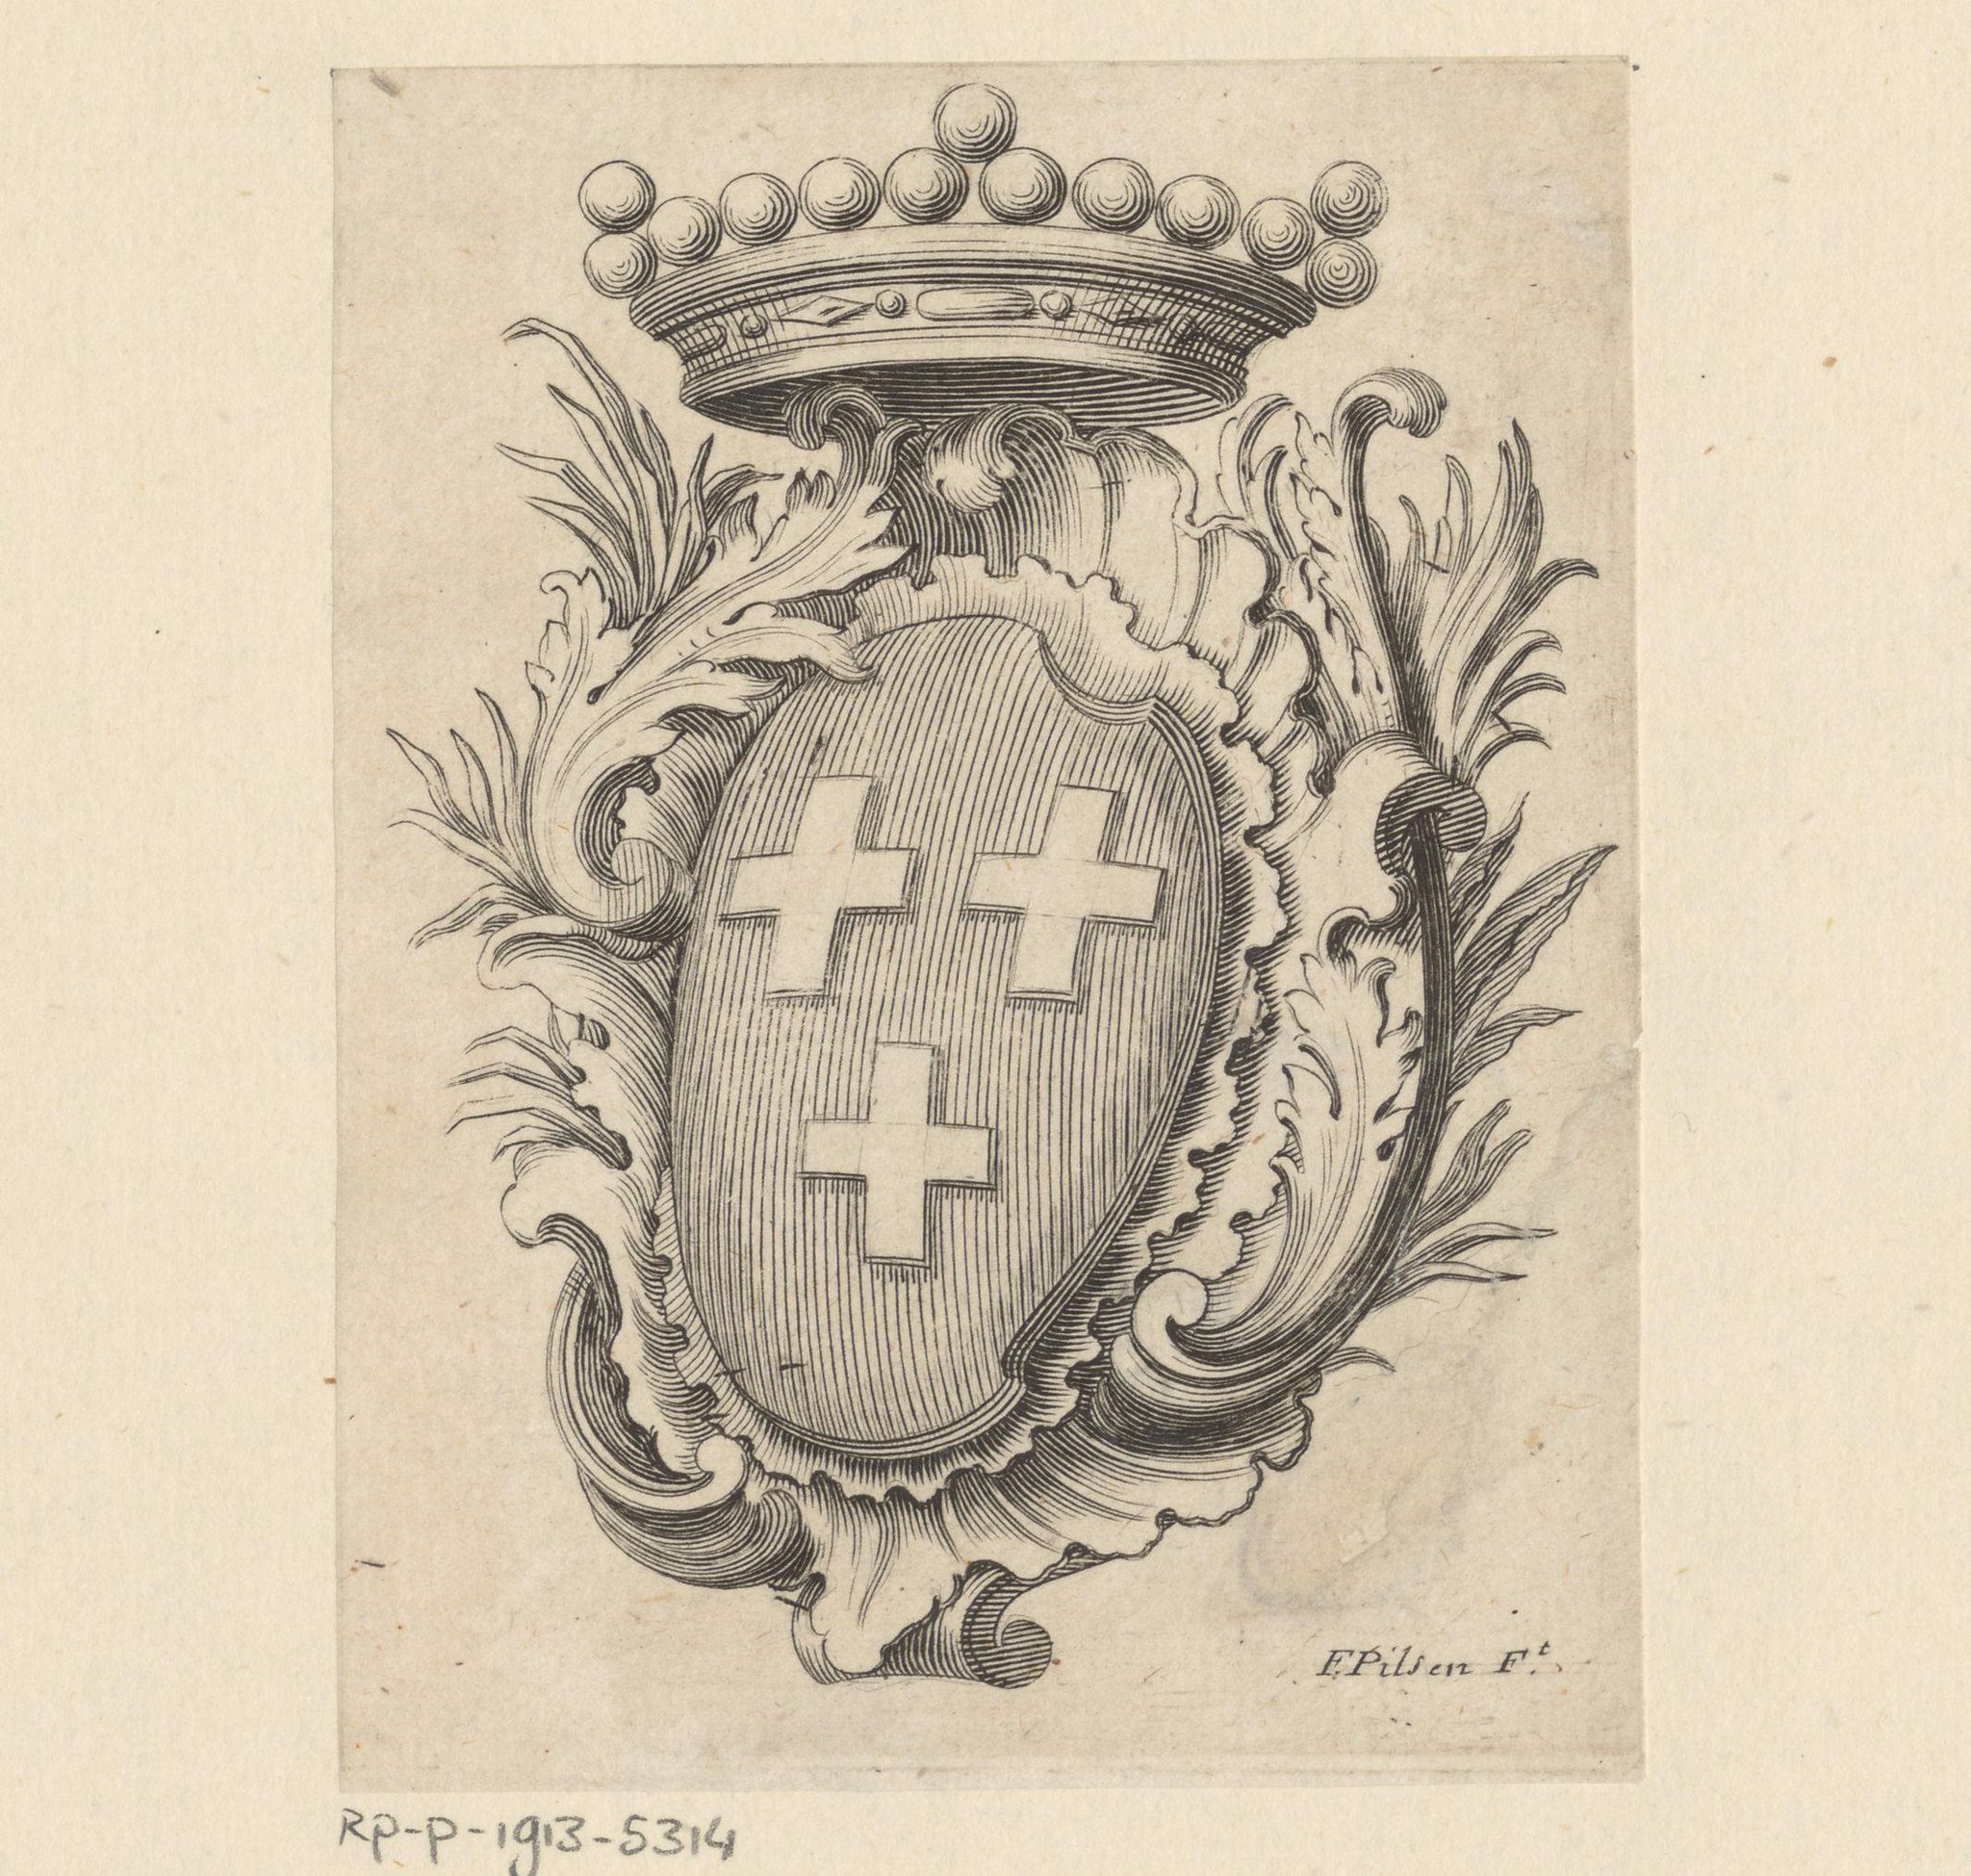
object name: bookplate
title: Ex libris van onbekend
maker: frans pilsen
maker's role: print maker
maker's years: 1700-1784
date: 1710-1784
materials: paper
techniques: engraving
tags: armorial bearing, heraldry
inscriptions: collector's mark: Lugt 2233, collector's mark: Lugt 2760